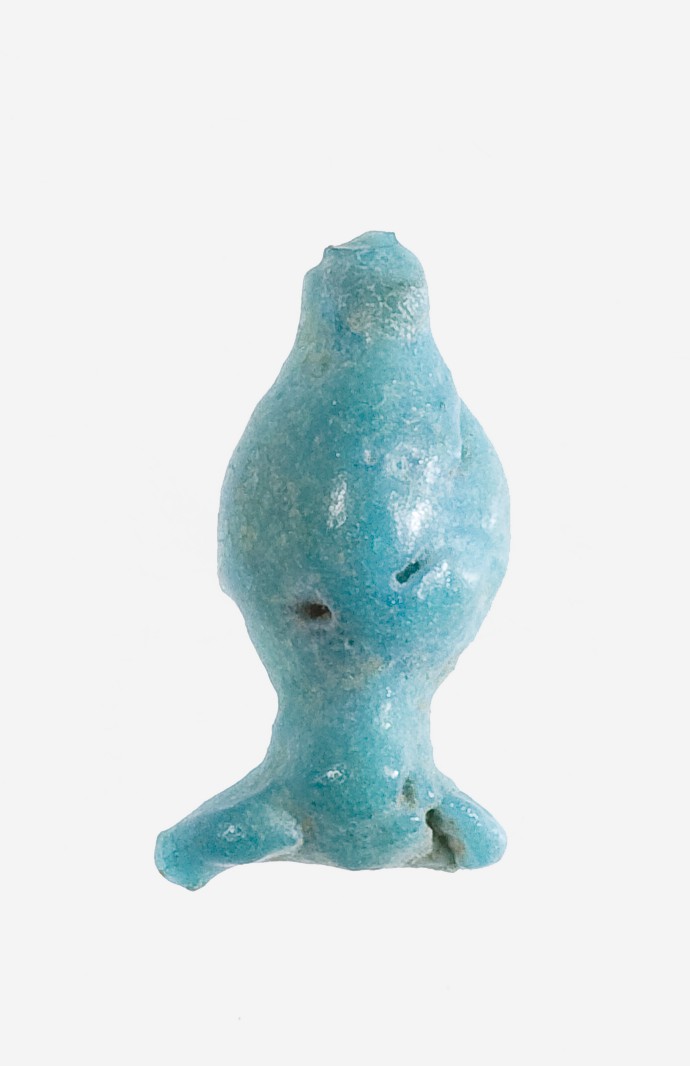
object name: pendant, cornflower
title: Cornflower Pendant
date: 1390-1352 BCE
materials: faience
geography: egypt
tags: flowers